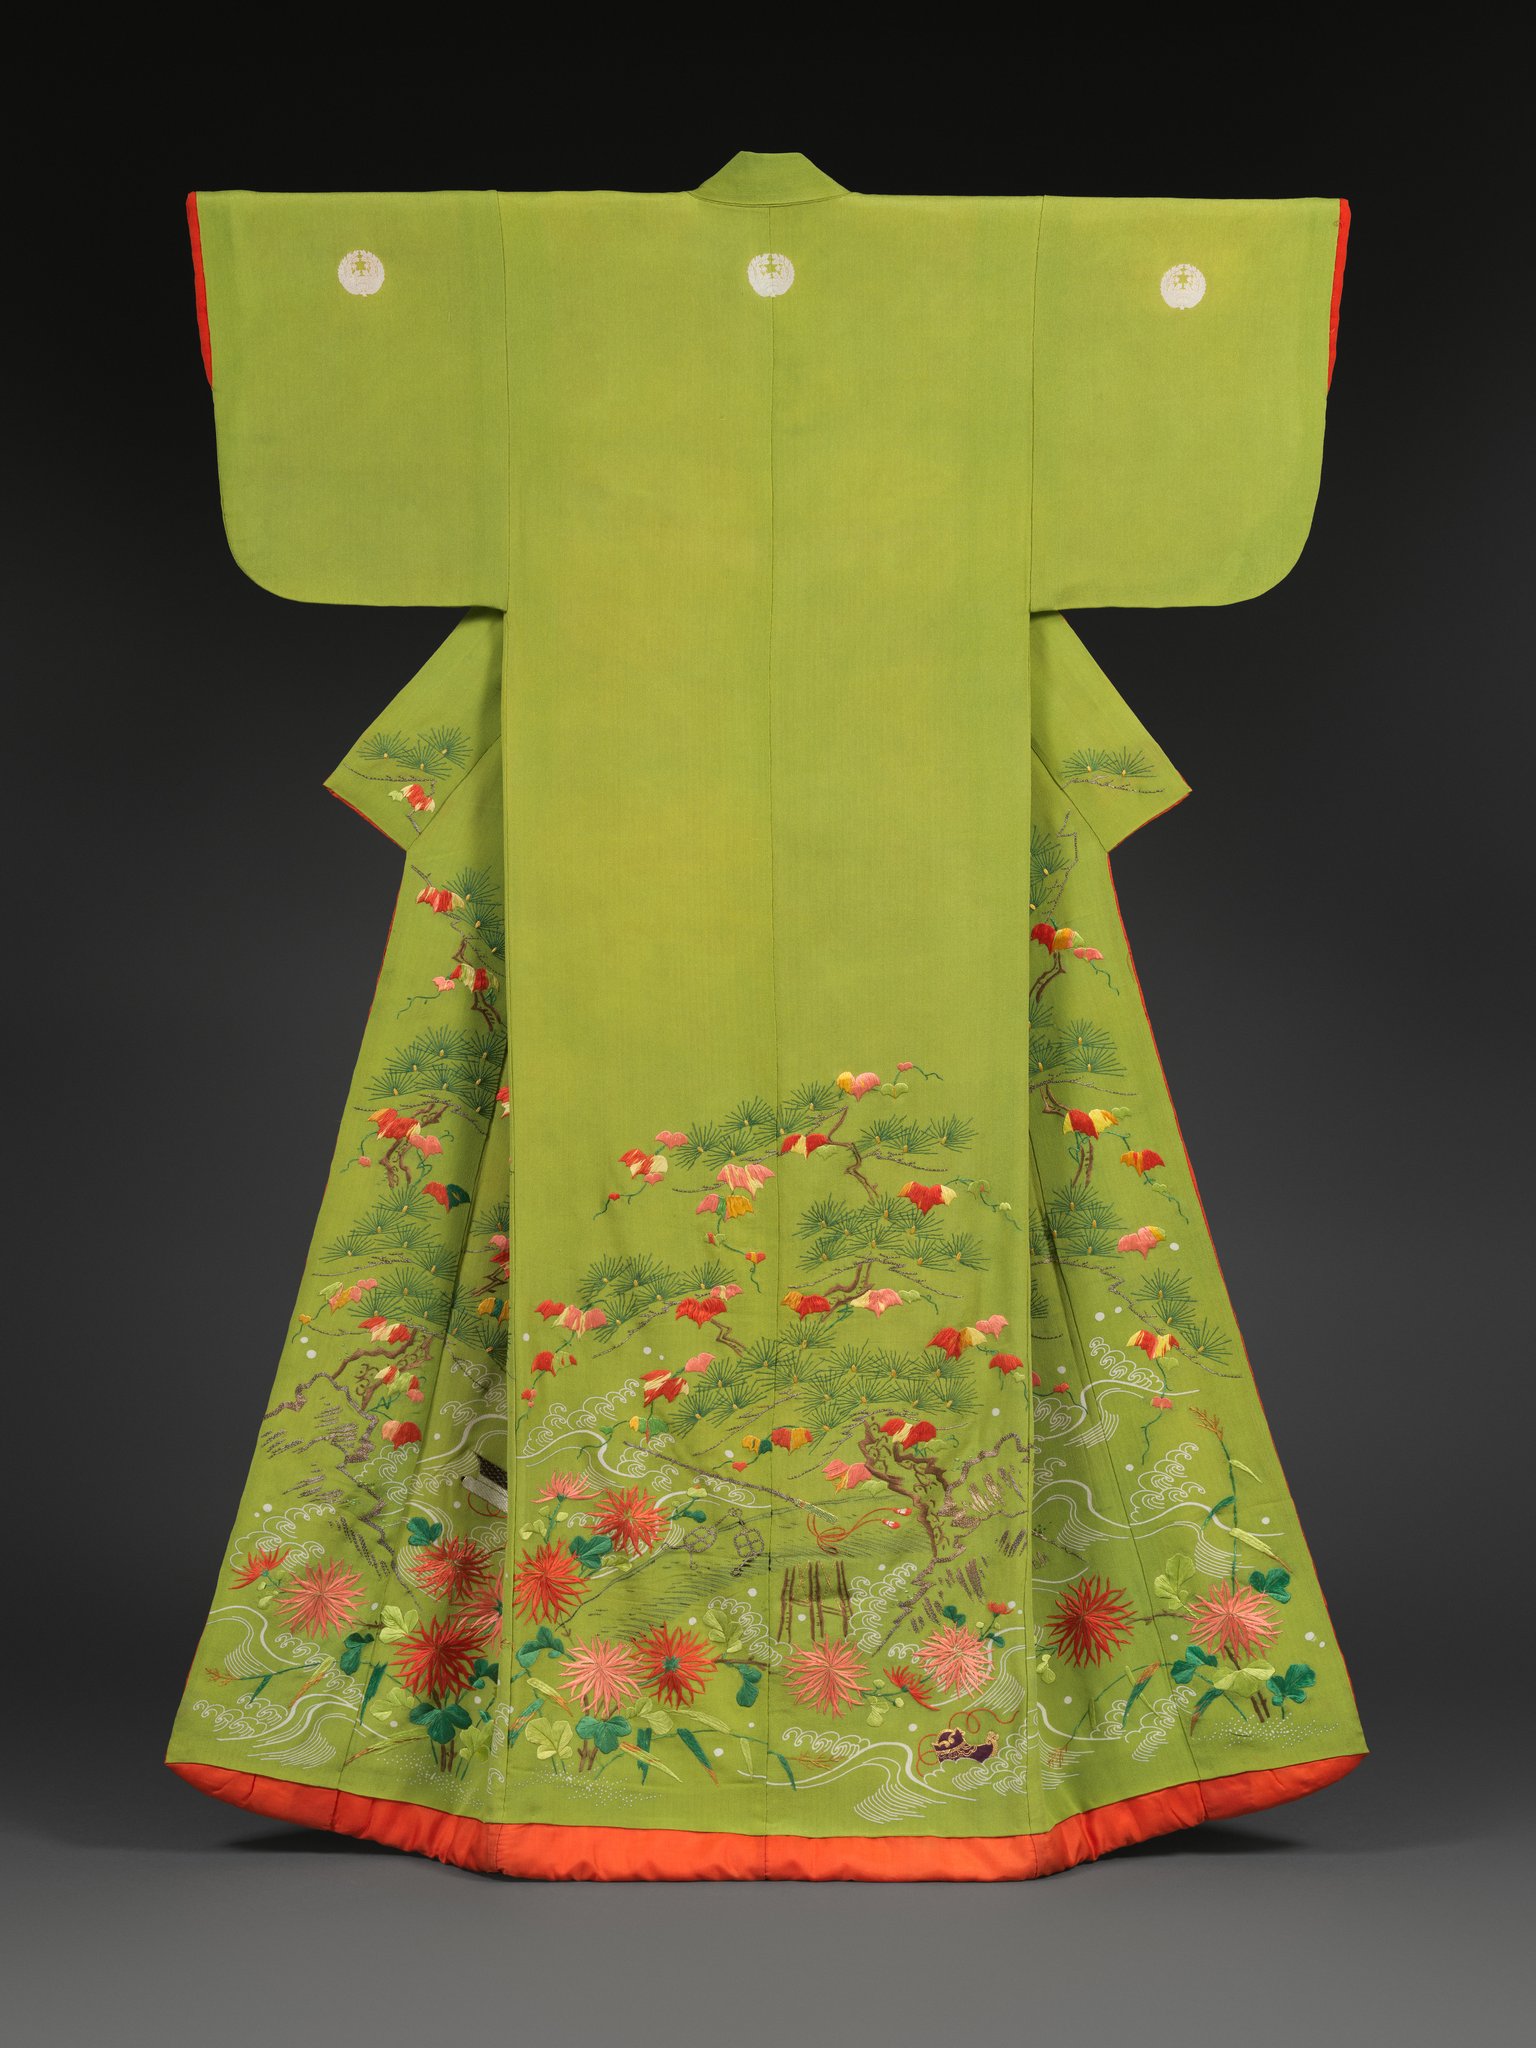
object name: robe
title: Robe (Kosode) with Pine, Ivy, Chrysanthemums, and River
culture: japanese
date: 1834-1866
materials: metal thread, silk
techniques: embroidery, resist